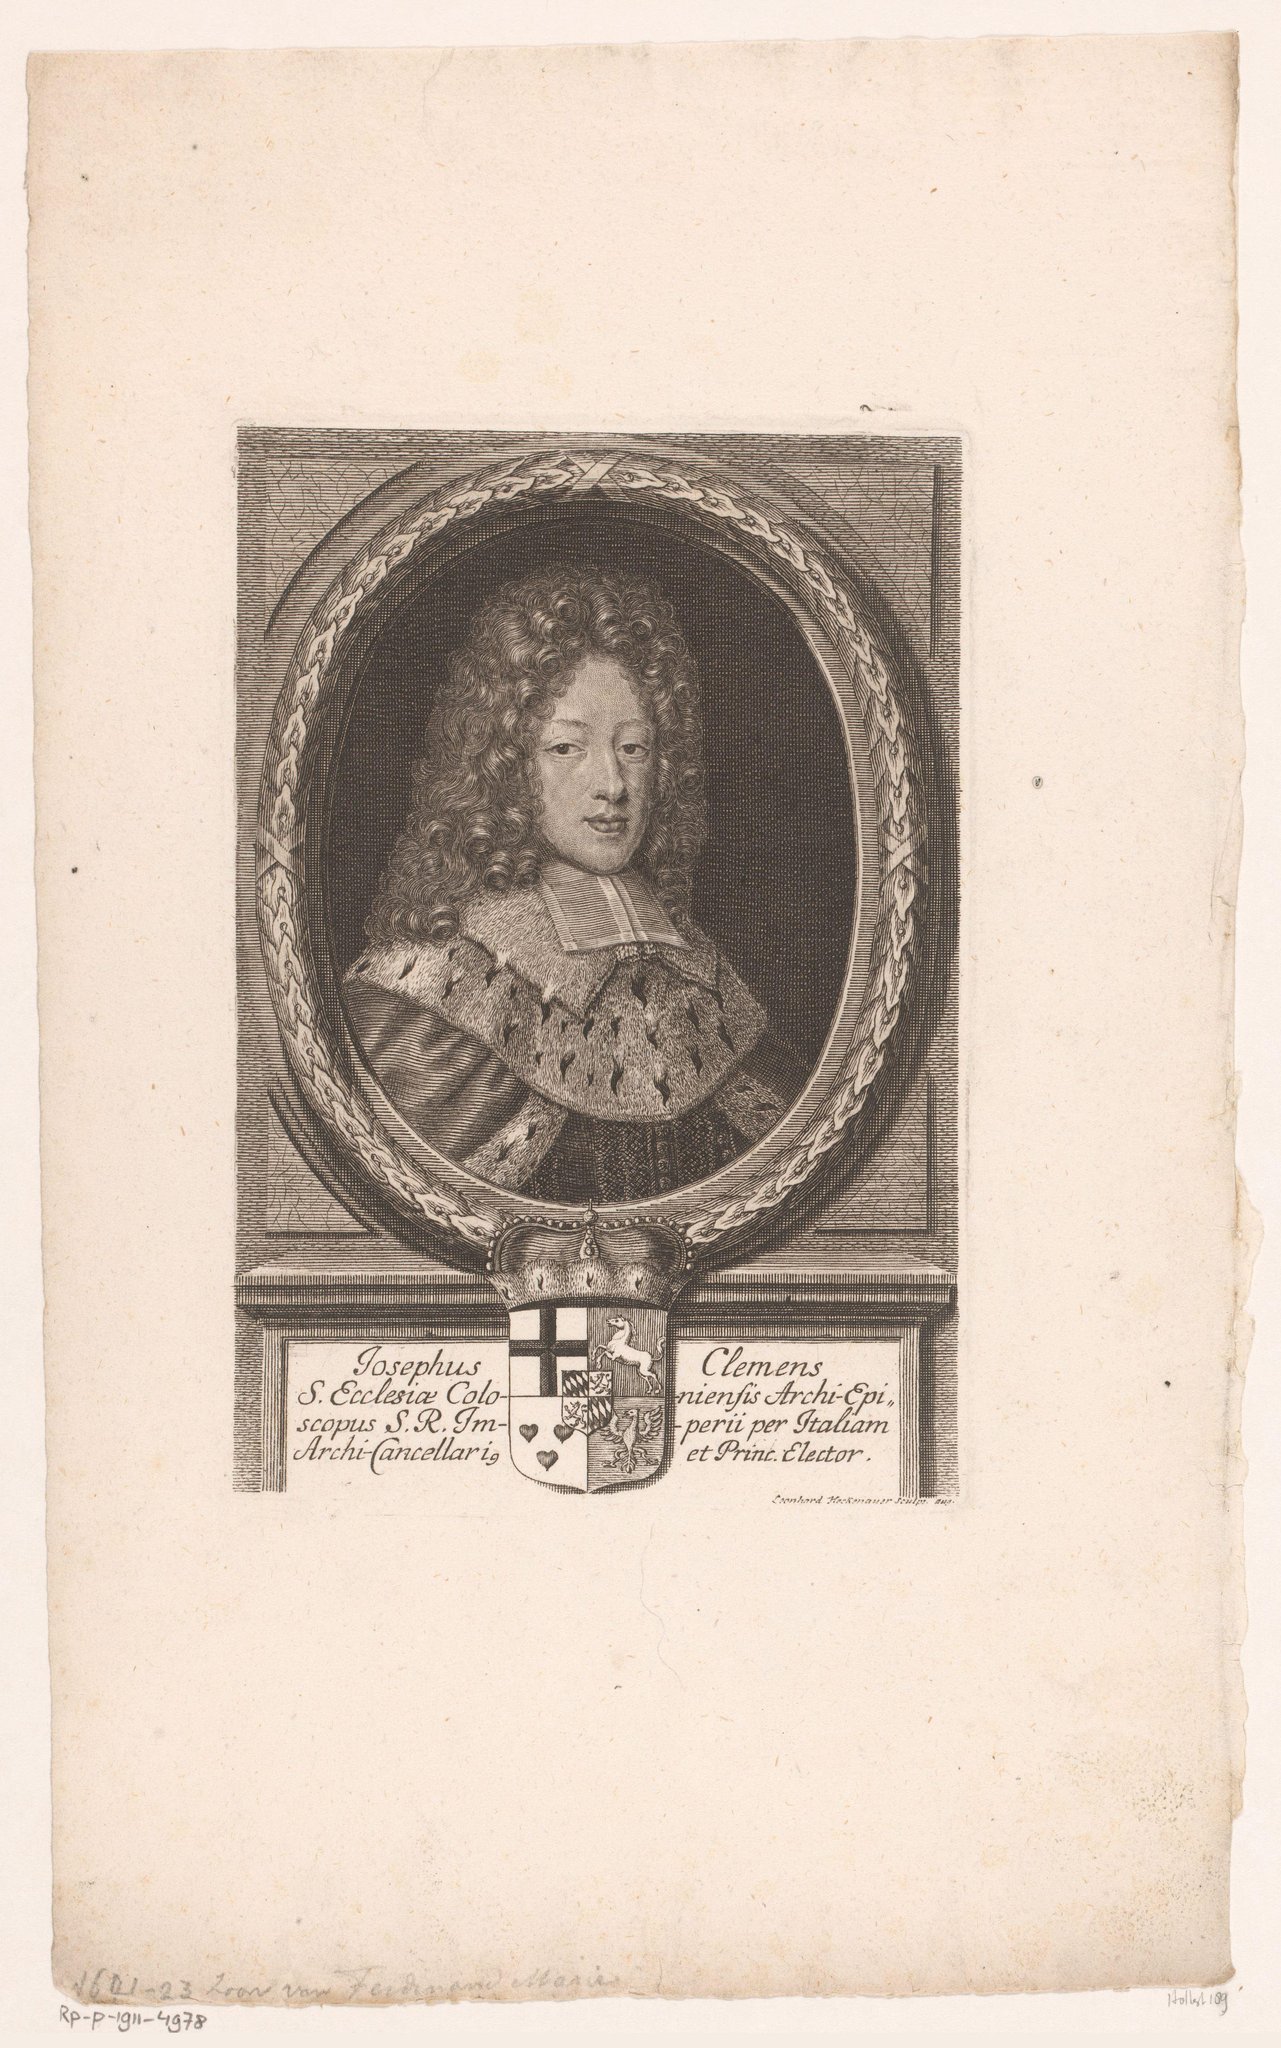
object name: print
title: Portret van Jozef Klemens van Beieren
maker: leonhard heckenauer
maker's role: print maker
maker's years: 1650-1704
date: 1690-1697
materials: paper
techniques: engraving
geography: augsburg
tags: priest, historical persons, ruler, sovereign, armorial bearing, heraldry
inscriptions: collector's mark: Lugt 2228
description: Prent gebruikt voor: Thucelius, Christian Leonhard. Austria S.R.Imperio Conjux (...). Augsburg: Lorenz Kroniger, [1690]. Of prent gebruikt voor: Thulemarius, Heinrich Günther. Tractatio de Bulla aurea, argentea, plumbea et cerea in genere, nec non in specie de Aurea Bulla Caroli IV Imperatoris (...). Frankfurt am Main: Johann Melchior Bencard, 1697.